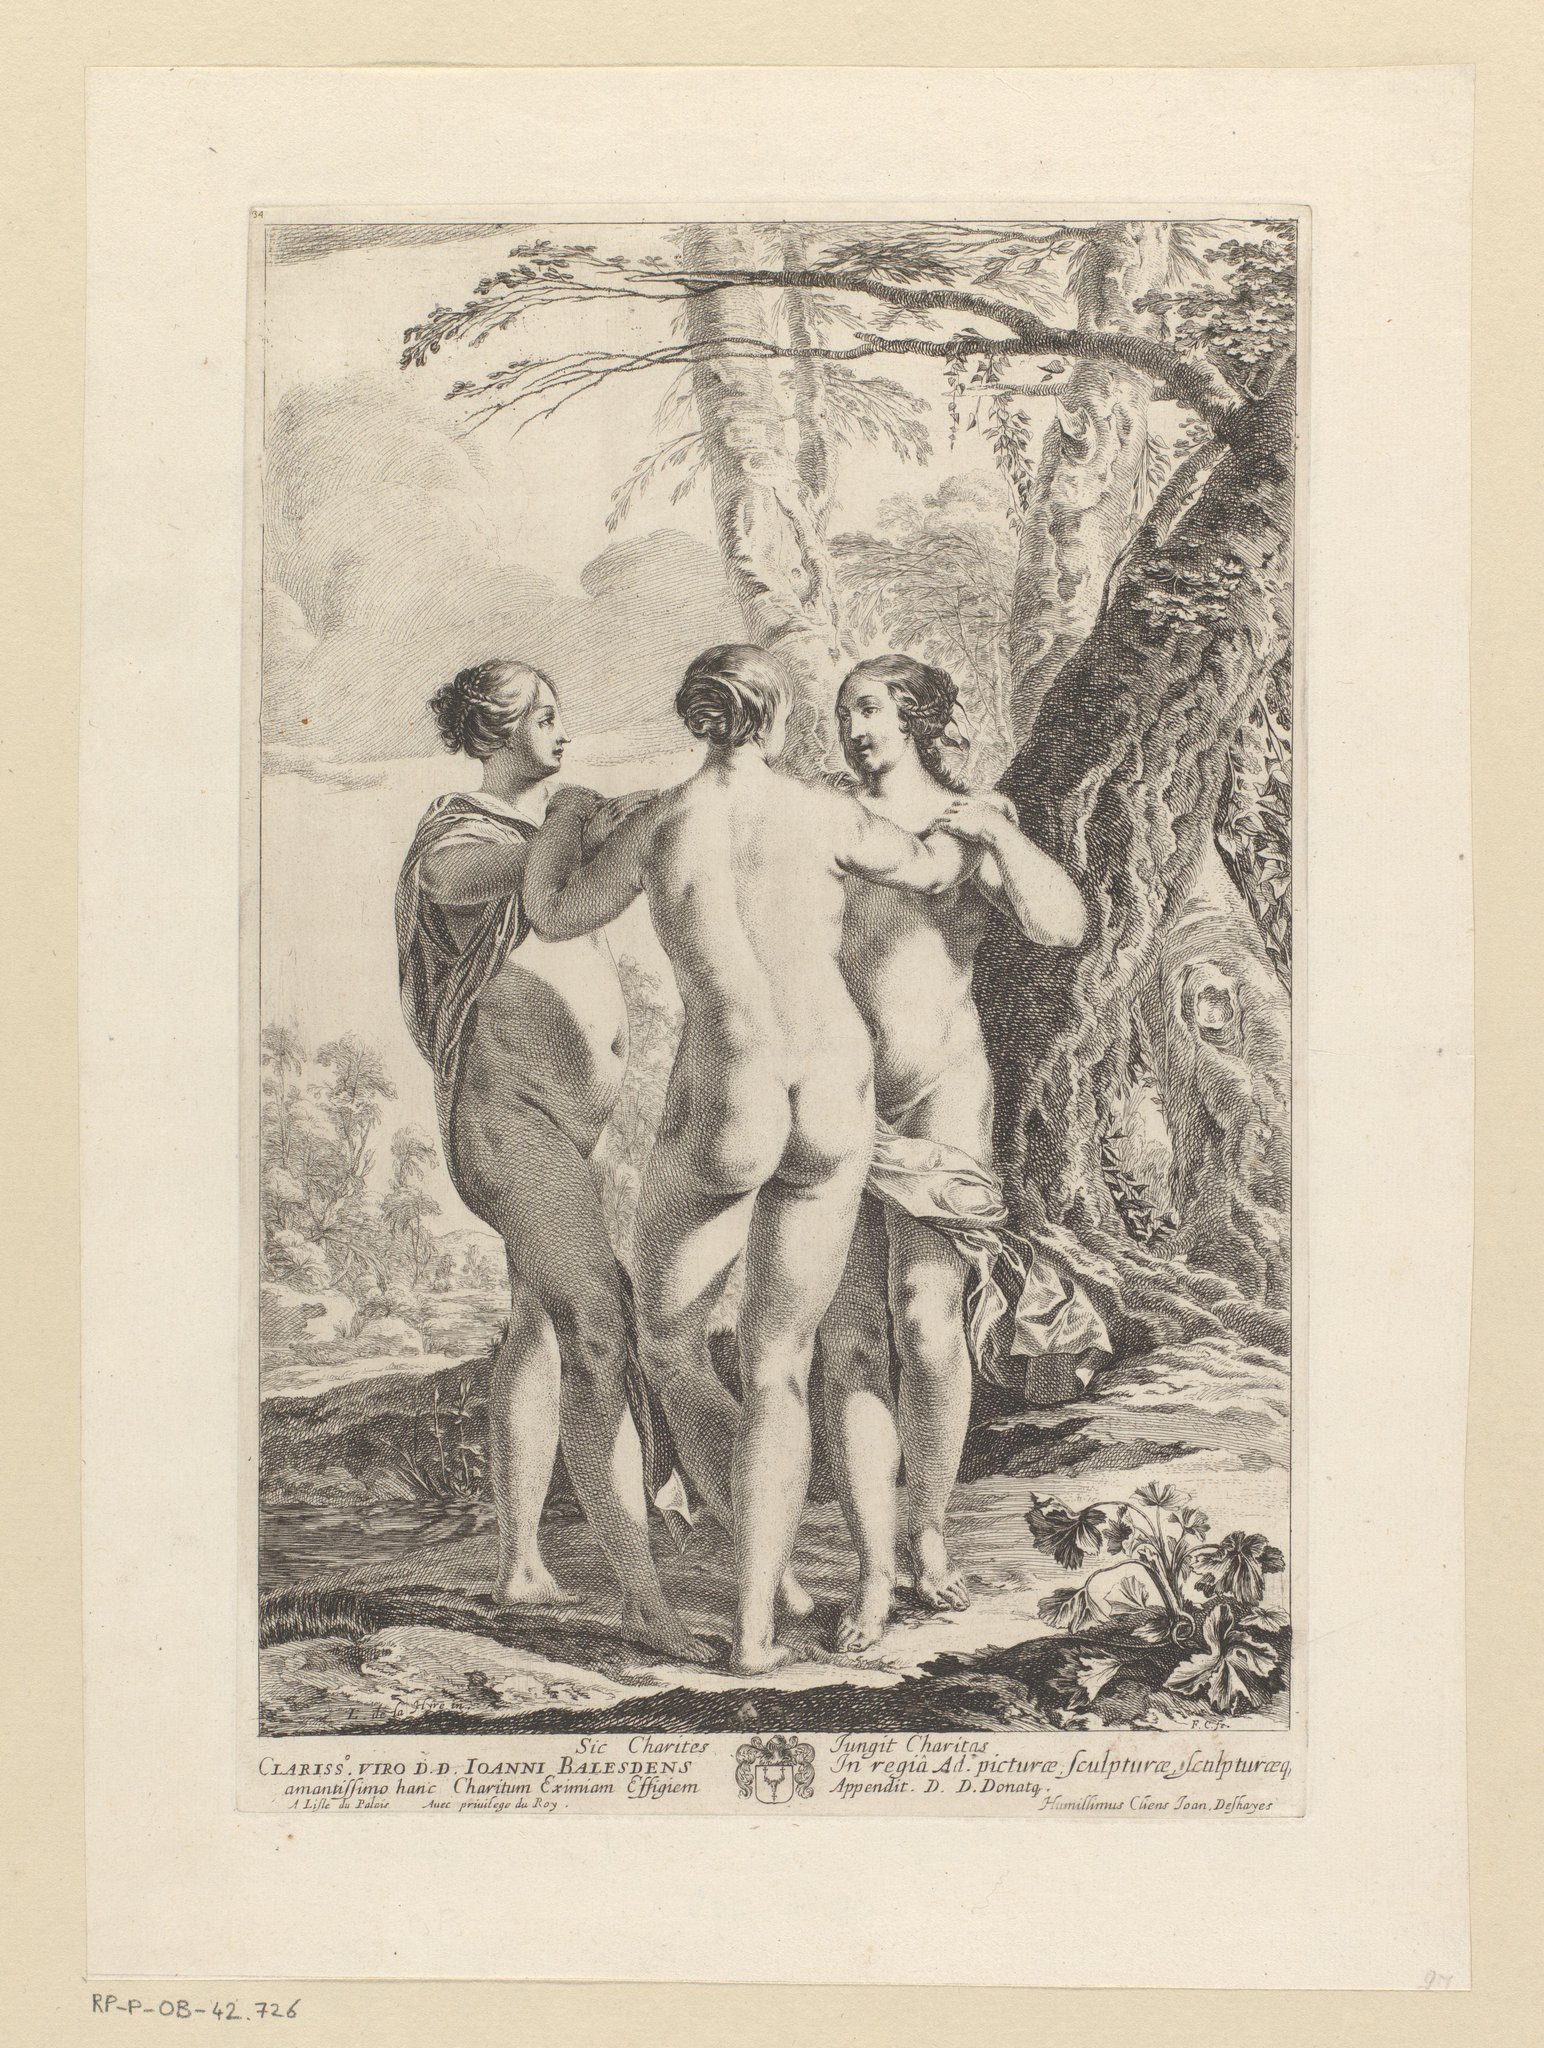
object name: print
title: Drie Gratiën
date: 1623-1676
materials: paper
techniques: engraving, etching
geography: france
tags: graces (charites), generally three in number; 'gratie' (ripa)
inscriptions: collector's mark: Lugt 240